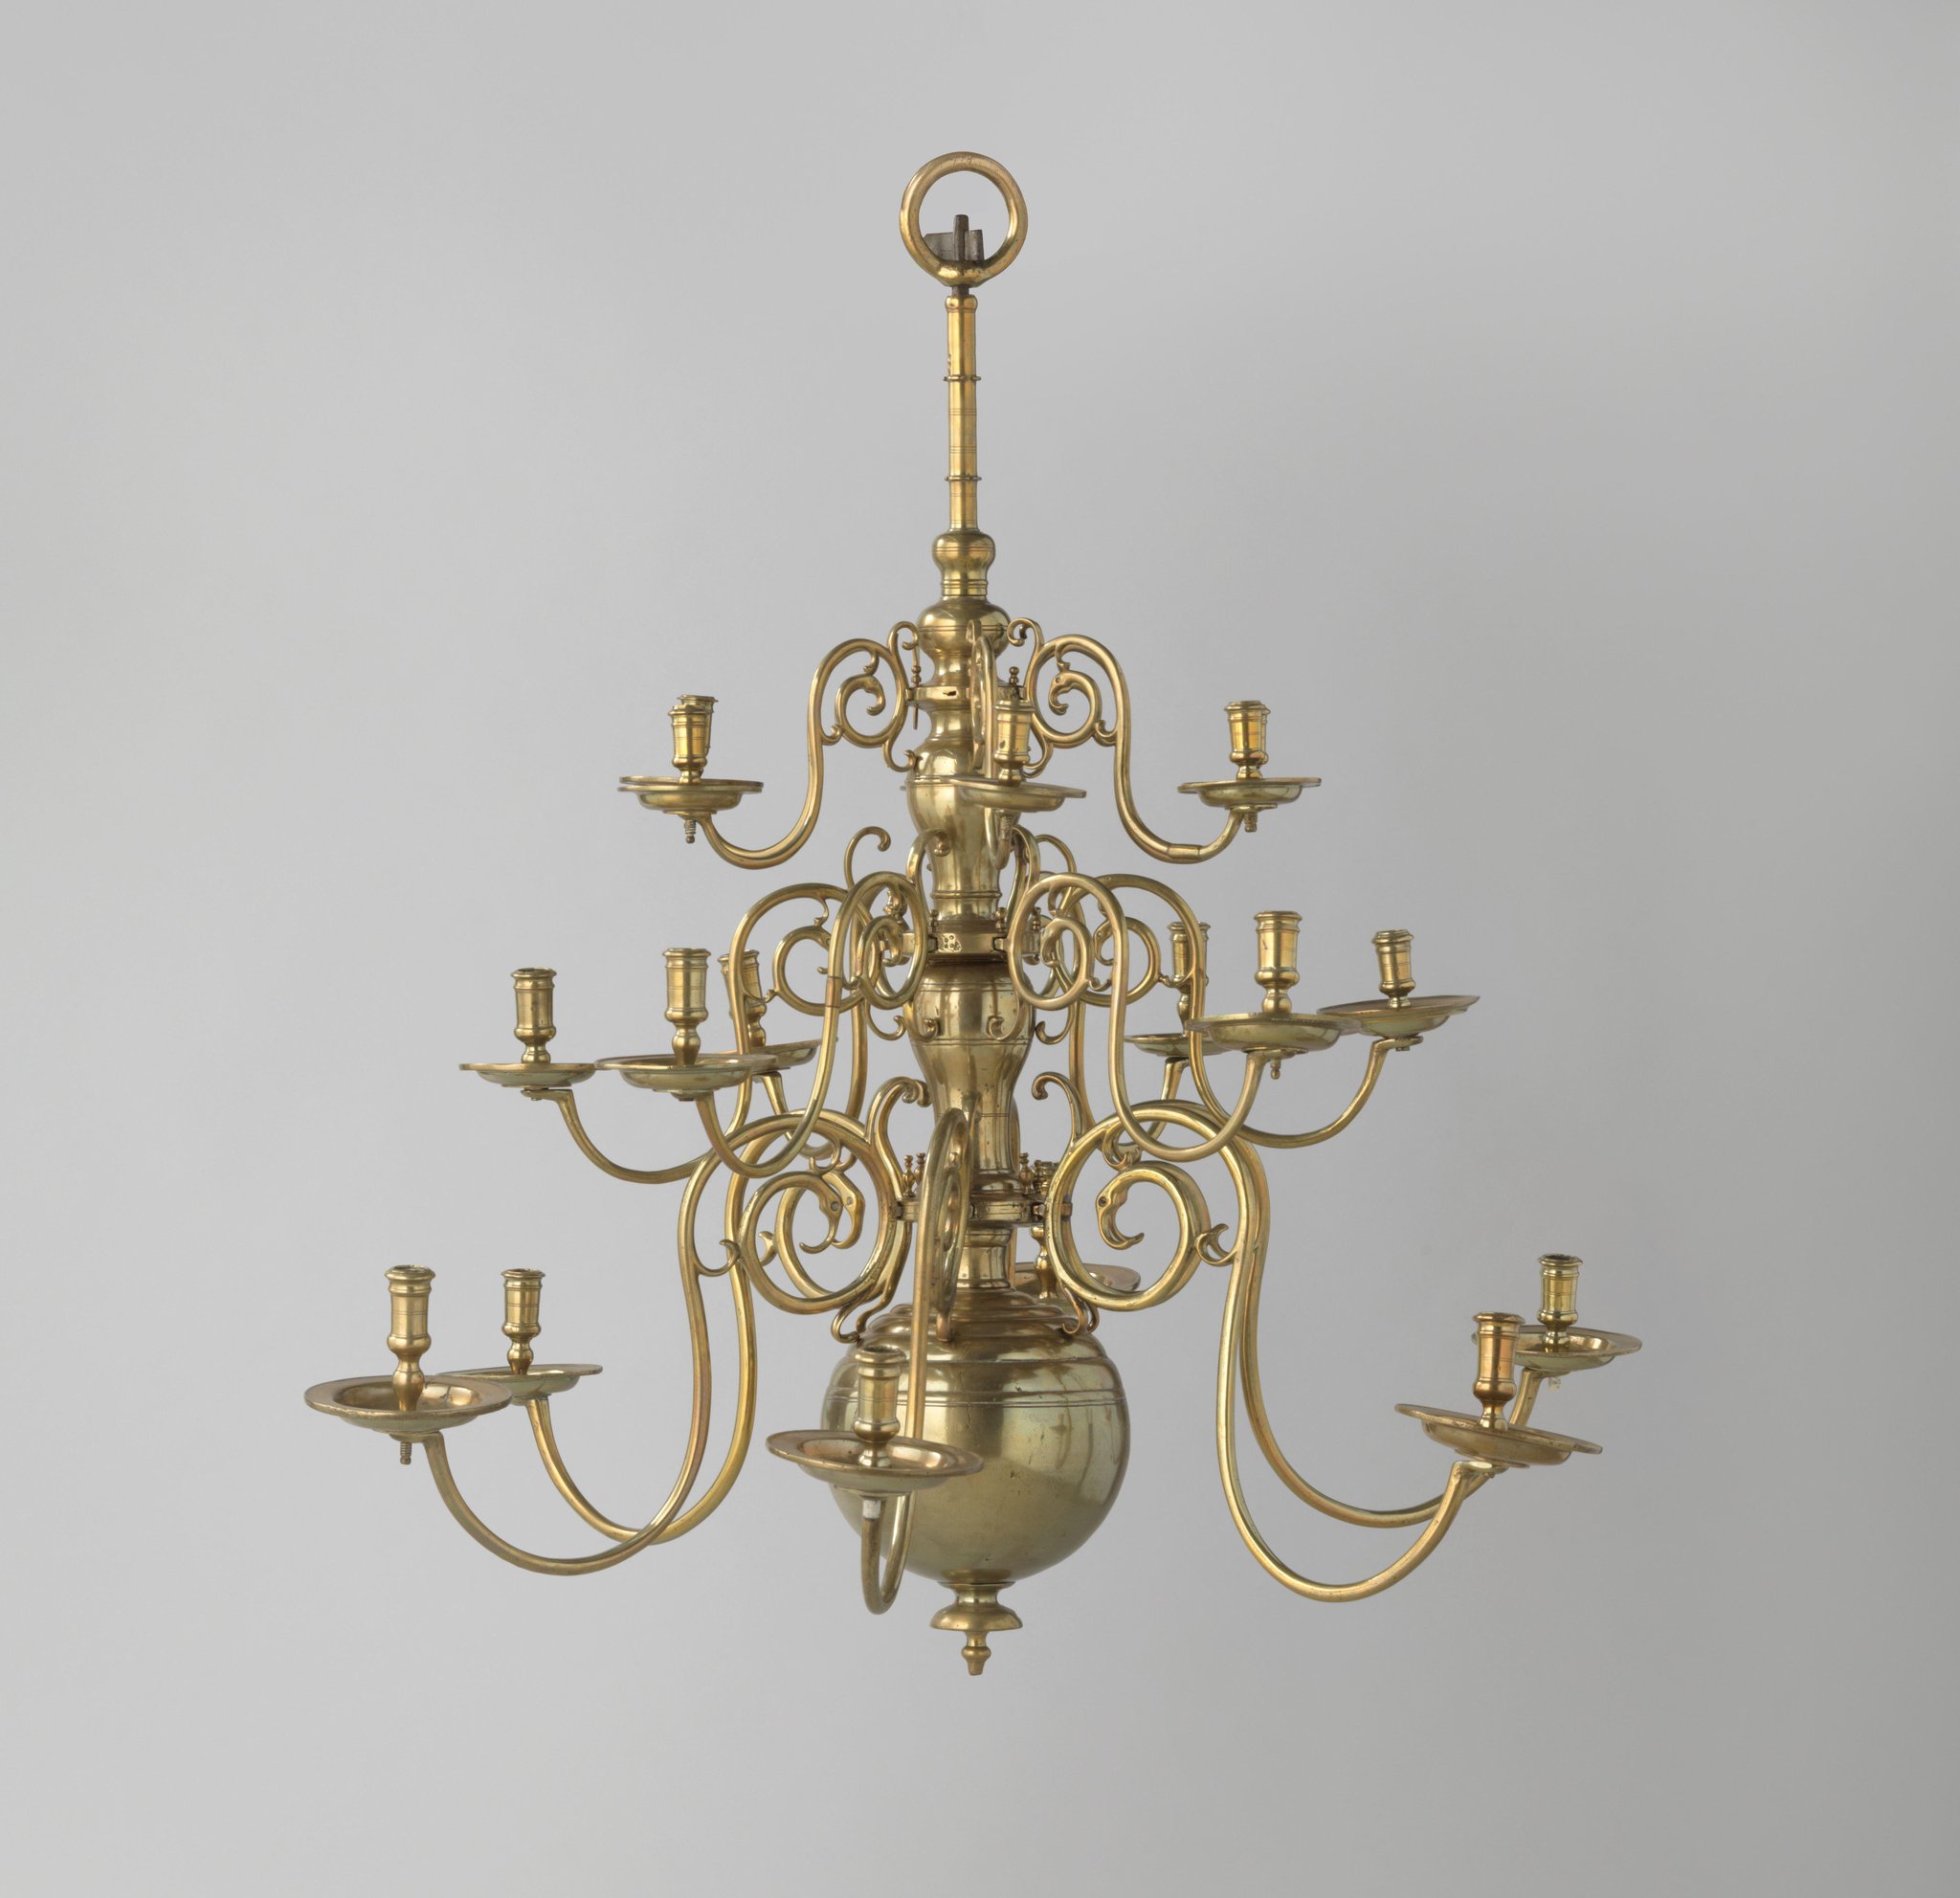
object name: chandelier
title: Arm met kaarsenhouder van kaarsenkroon van drie hoogten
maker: Anonymous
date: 1675-1725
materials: brass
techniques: casting, turning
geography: southern netherlands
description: Kaarsenarm behorende bij een messing kaarsenkroon van drie hoogten. De S-vormige arm heeft een krul en gaat naar buiten toe over in het platte verdikking met een schroefgat. Daarin is de kaarsenhouder met de vetvanger vastgezet. De vetvanger is aan de onderzijde geribd geprofileerd rond de opening en heeft verder twee maal twee gegroefde ringen. De cylindrische kaarsenhouder, die een geprofileerde uitstekende rand, twee gegroefde ringen en een verdikking onderaan heeft, gaat over in een baluster met onderaan het eind met schroefdraad en een knopje, waarin het centergat te zien is. Dit is de vierde arm van de bovenste standring, genummerd met 4 ronde punten. De pin, om de arm aan de standring te bevestigen, heeft bovenop een ronde knop.